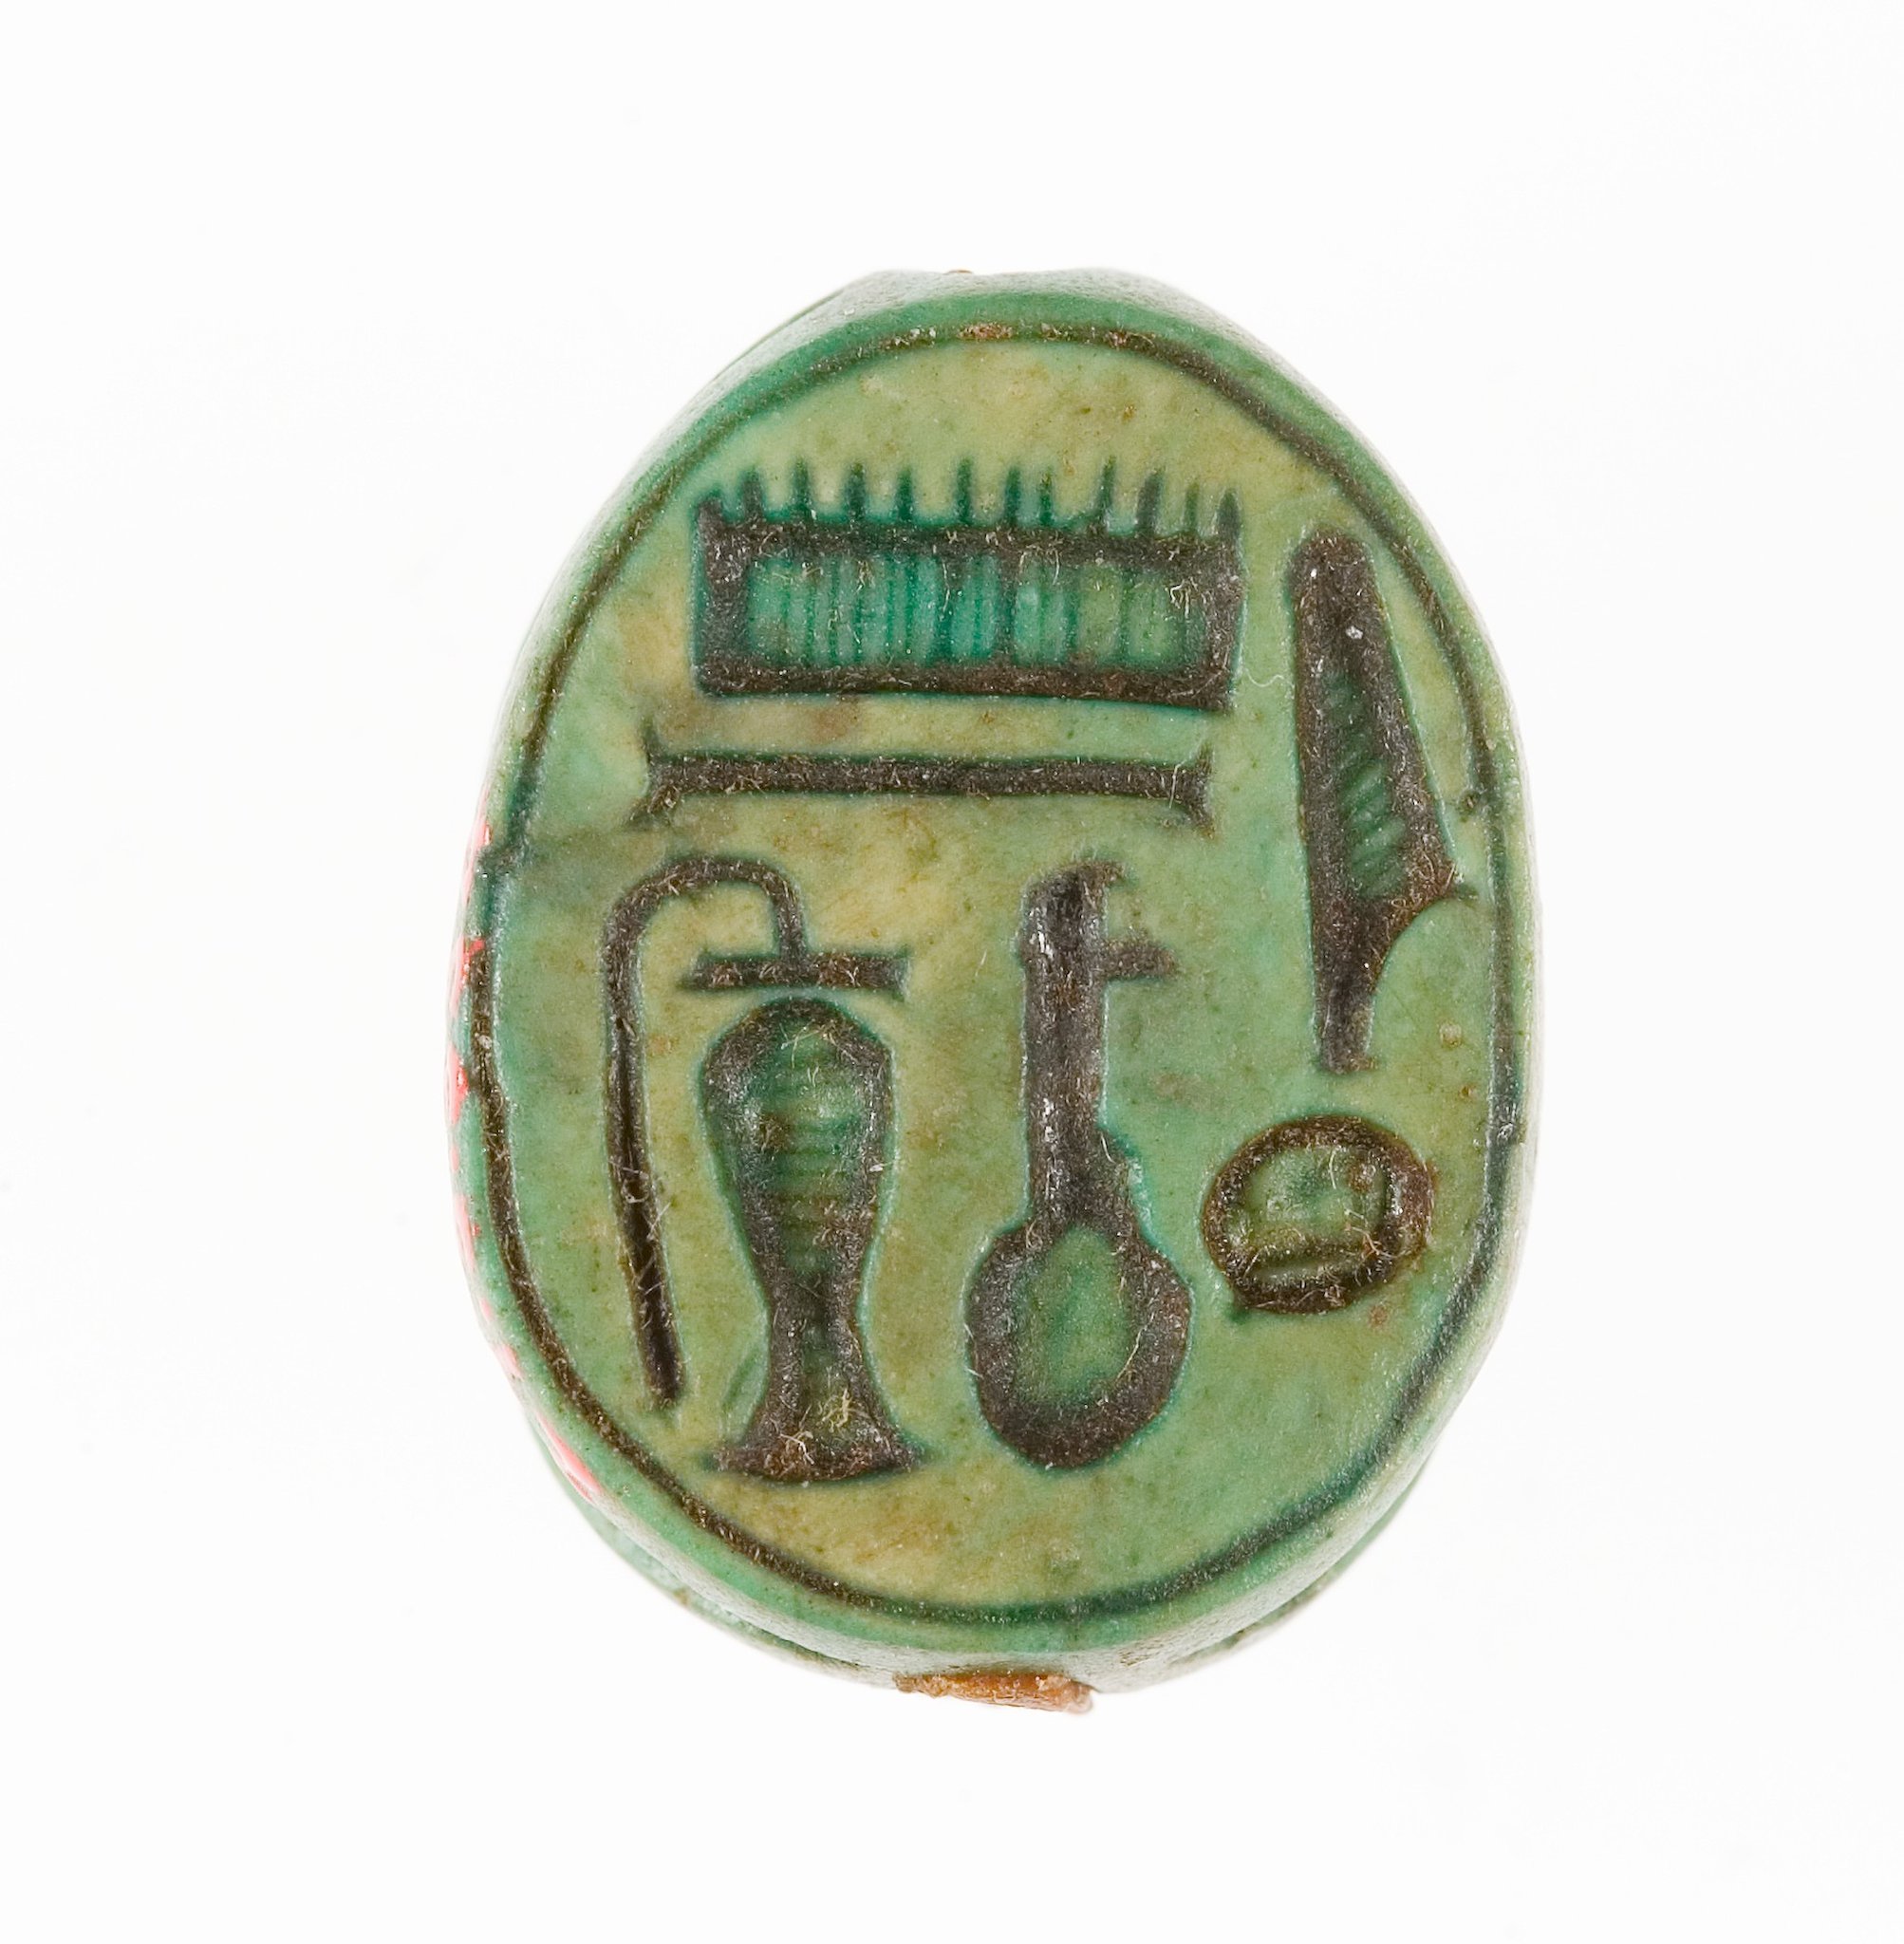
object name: scarab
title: Scarab Inscribed with the Name of the God Amun-Re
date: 1479-1458 BCE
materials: stone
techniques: glazing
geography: egypt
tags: hieroglyphs,scarabs